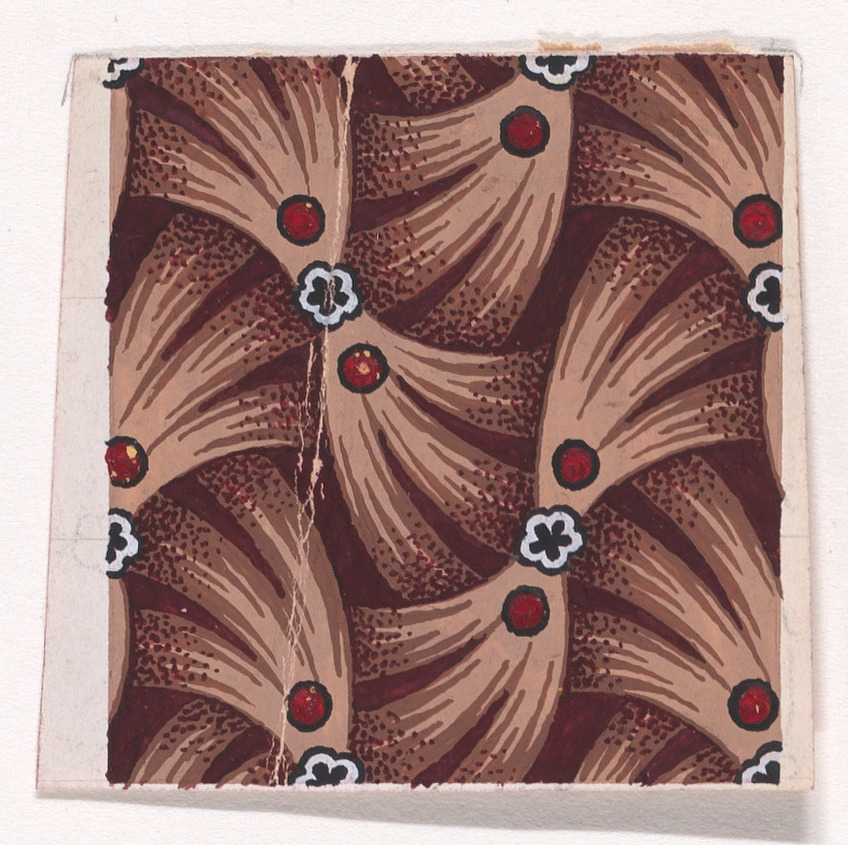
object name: drawing ornament architecture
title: Textile Design with Alternating Rows of Bundles of Hay Decorated with Rosettes and Pearls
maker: anonymous, alsatian, 19th century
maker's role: artist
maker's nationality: alsatian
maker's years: 1800-1900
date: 1840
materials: gouache